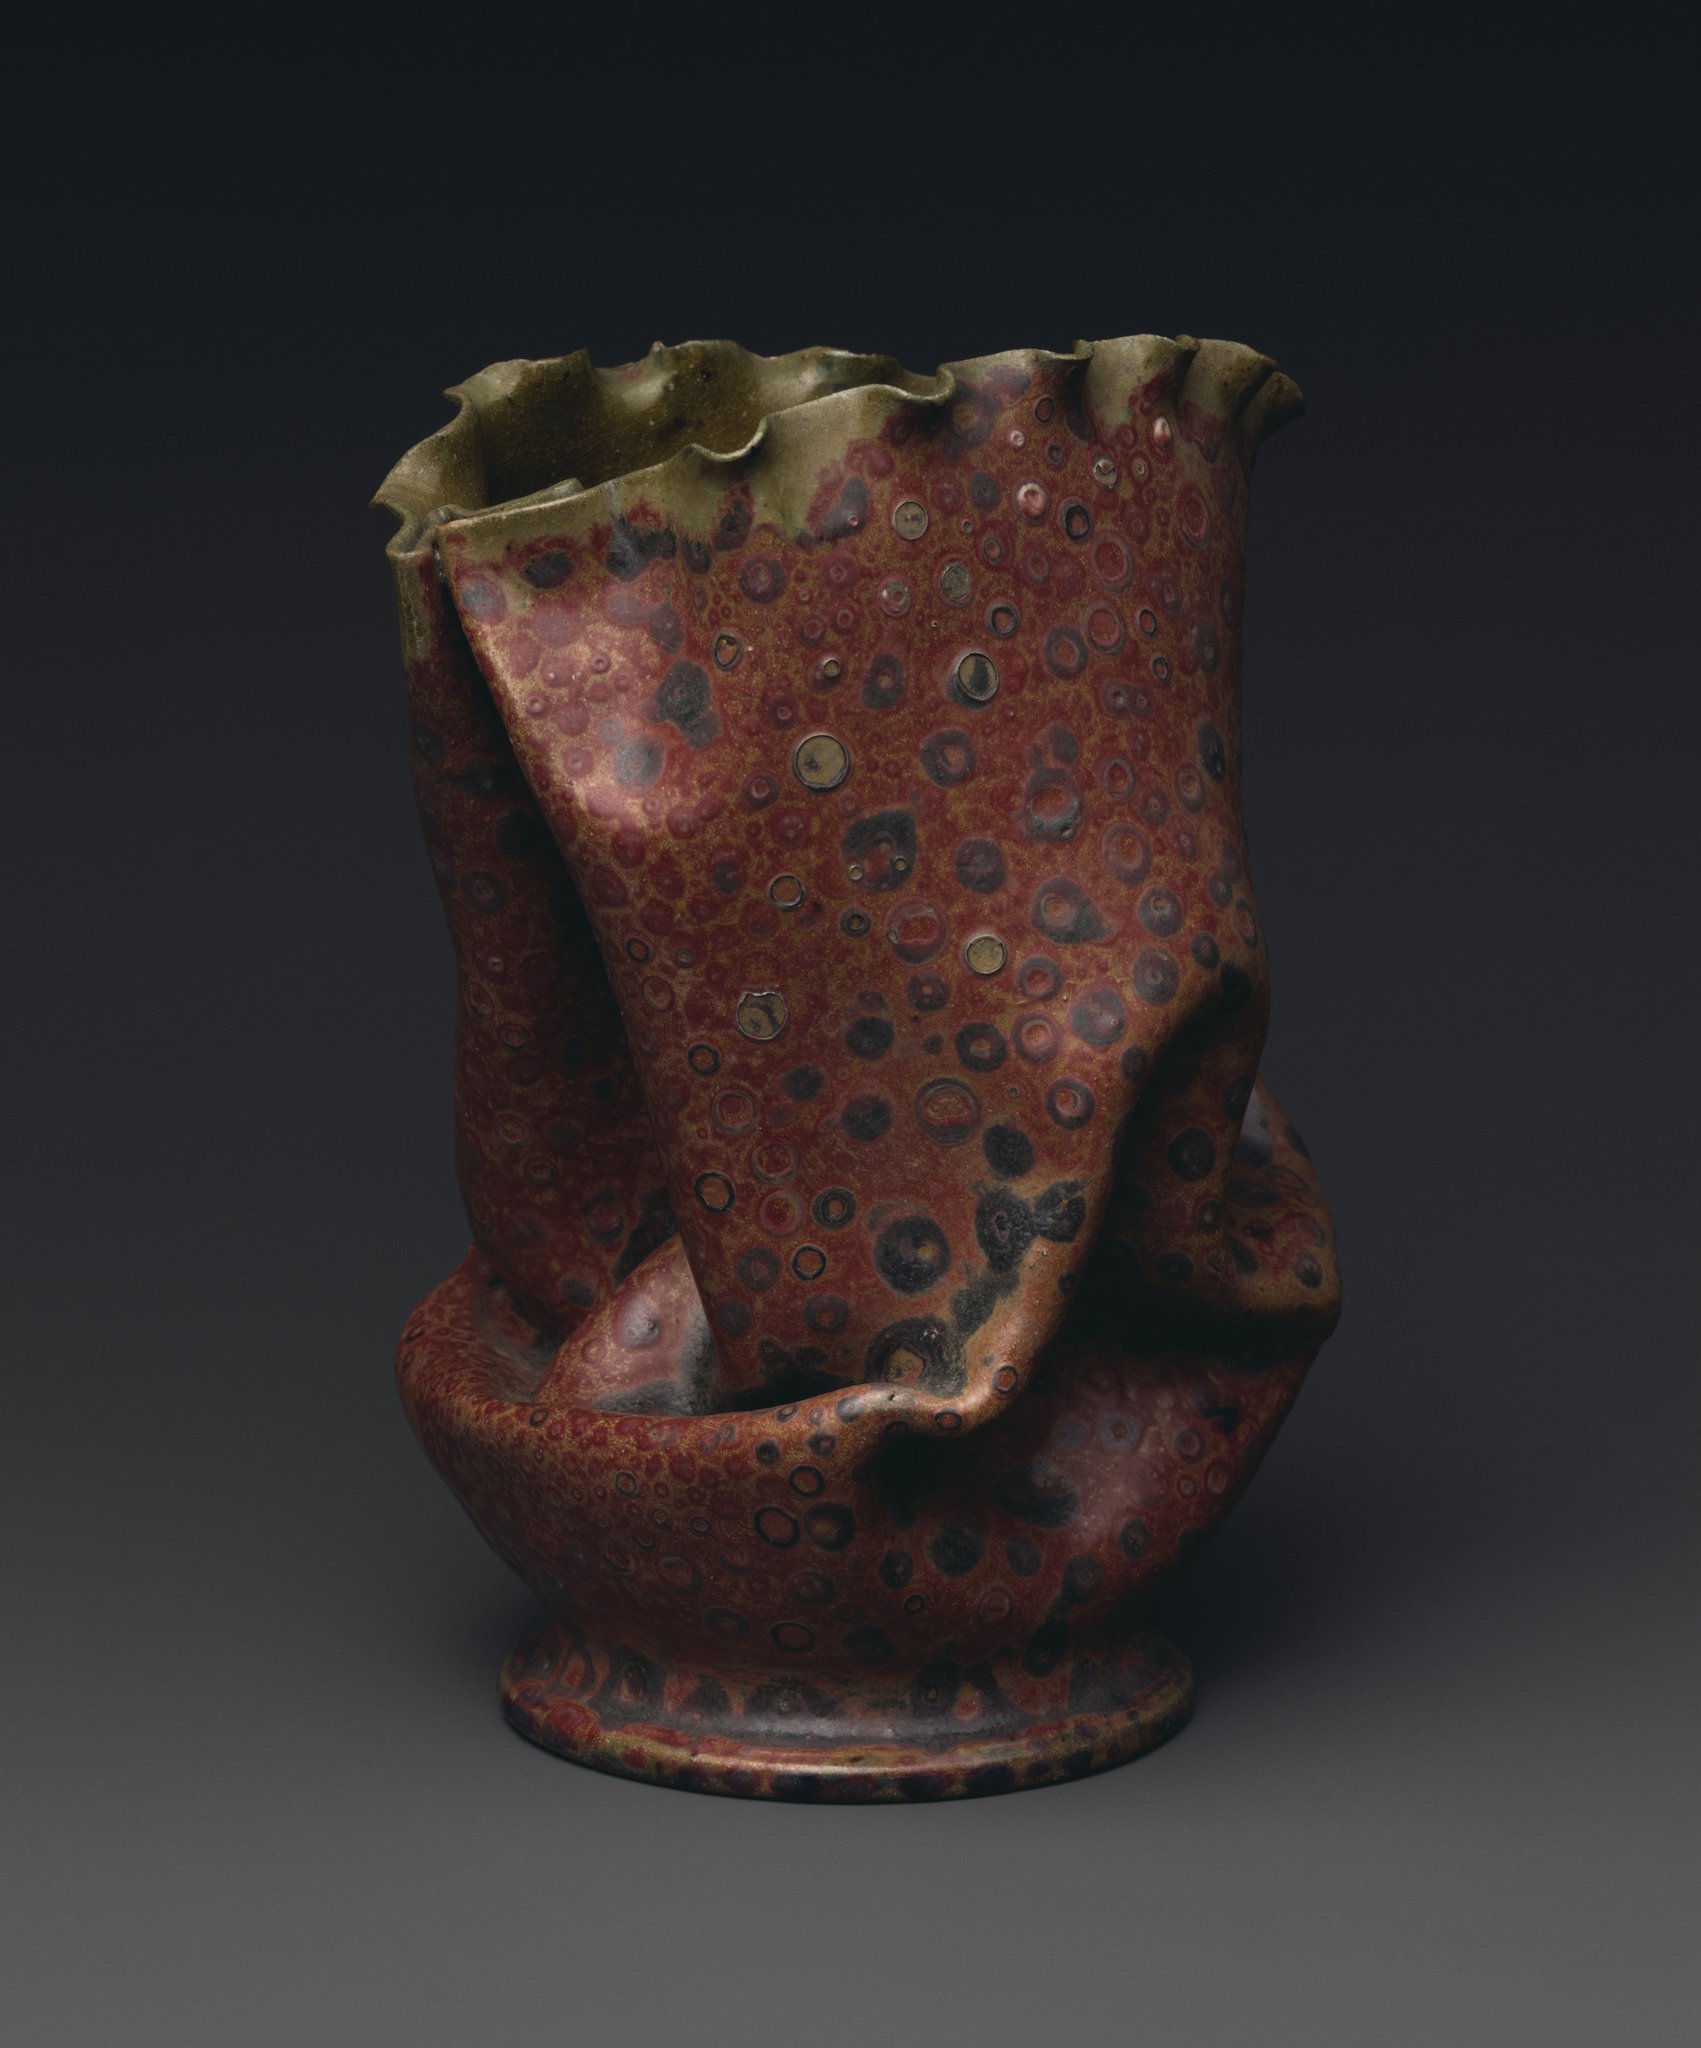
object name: vase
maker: george e. ohr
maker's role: maker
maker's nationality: american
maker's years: 1857-1918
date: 1897-1900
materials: earthenware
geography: united states